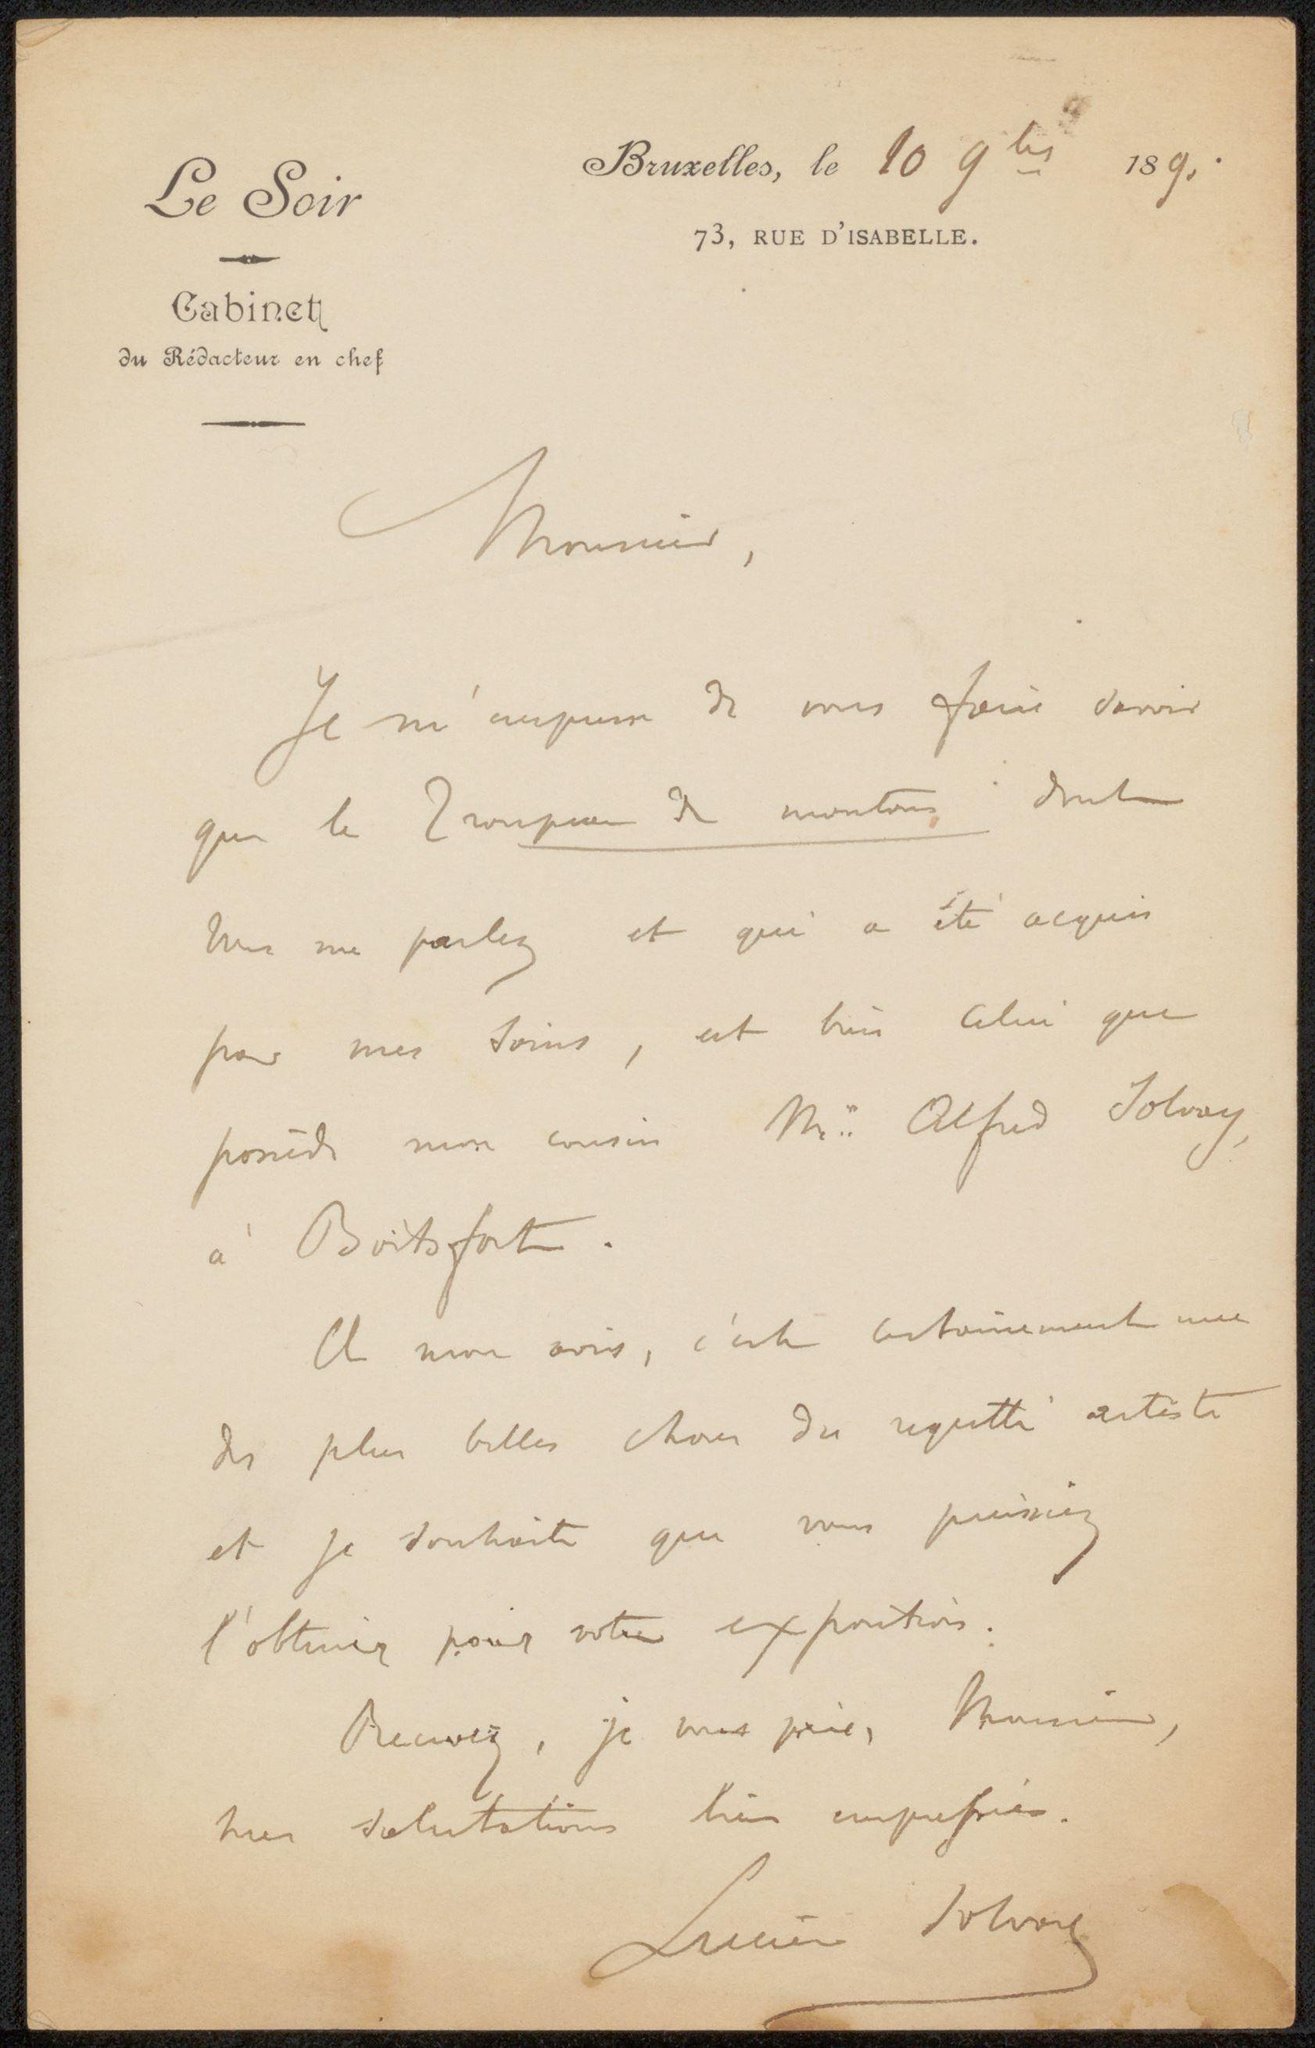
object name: letter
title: Brief aan Philip Zilcken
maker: lucien solvay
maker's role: criticus, hoofdredacteur, letterkundige, vertaler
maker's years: 1851-1950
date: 1891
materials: ink, paper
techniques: pen, printing, writing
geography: brussels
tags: the hague, painter, draughtsman, philip zilcken, exhibition ~ art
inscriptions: collector's mark: ‘RPK’